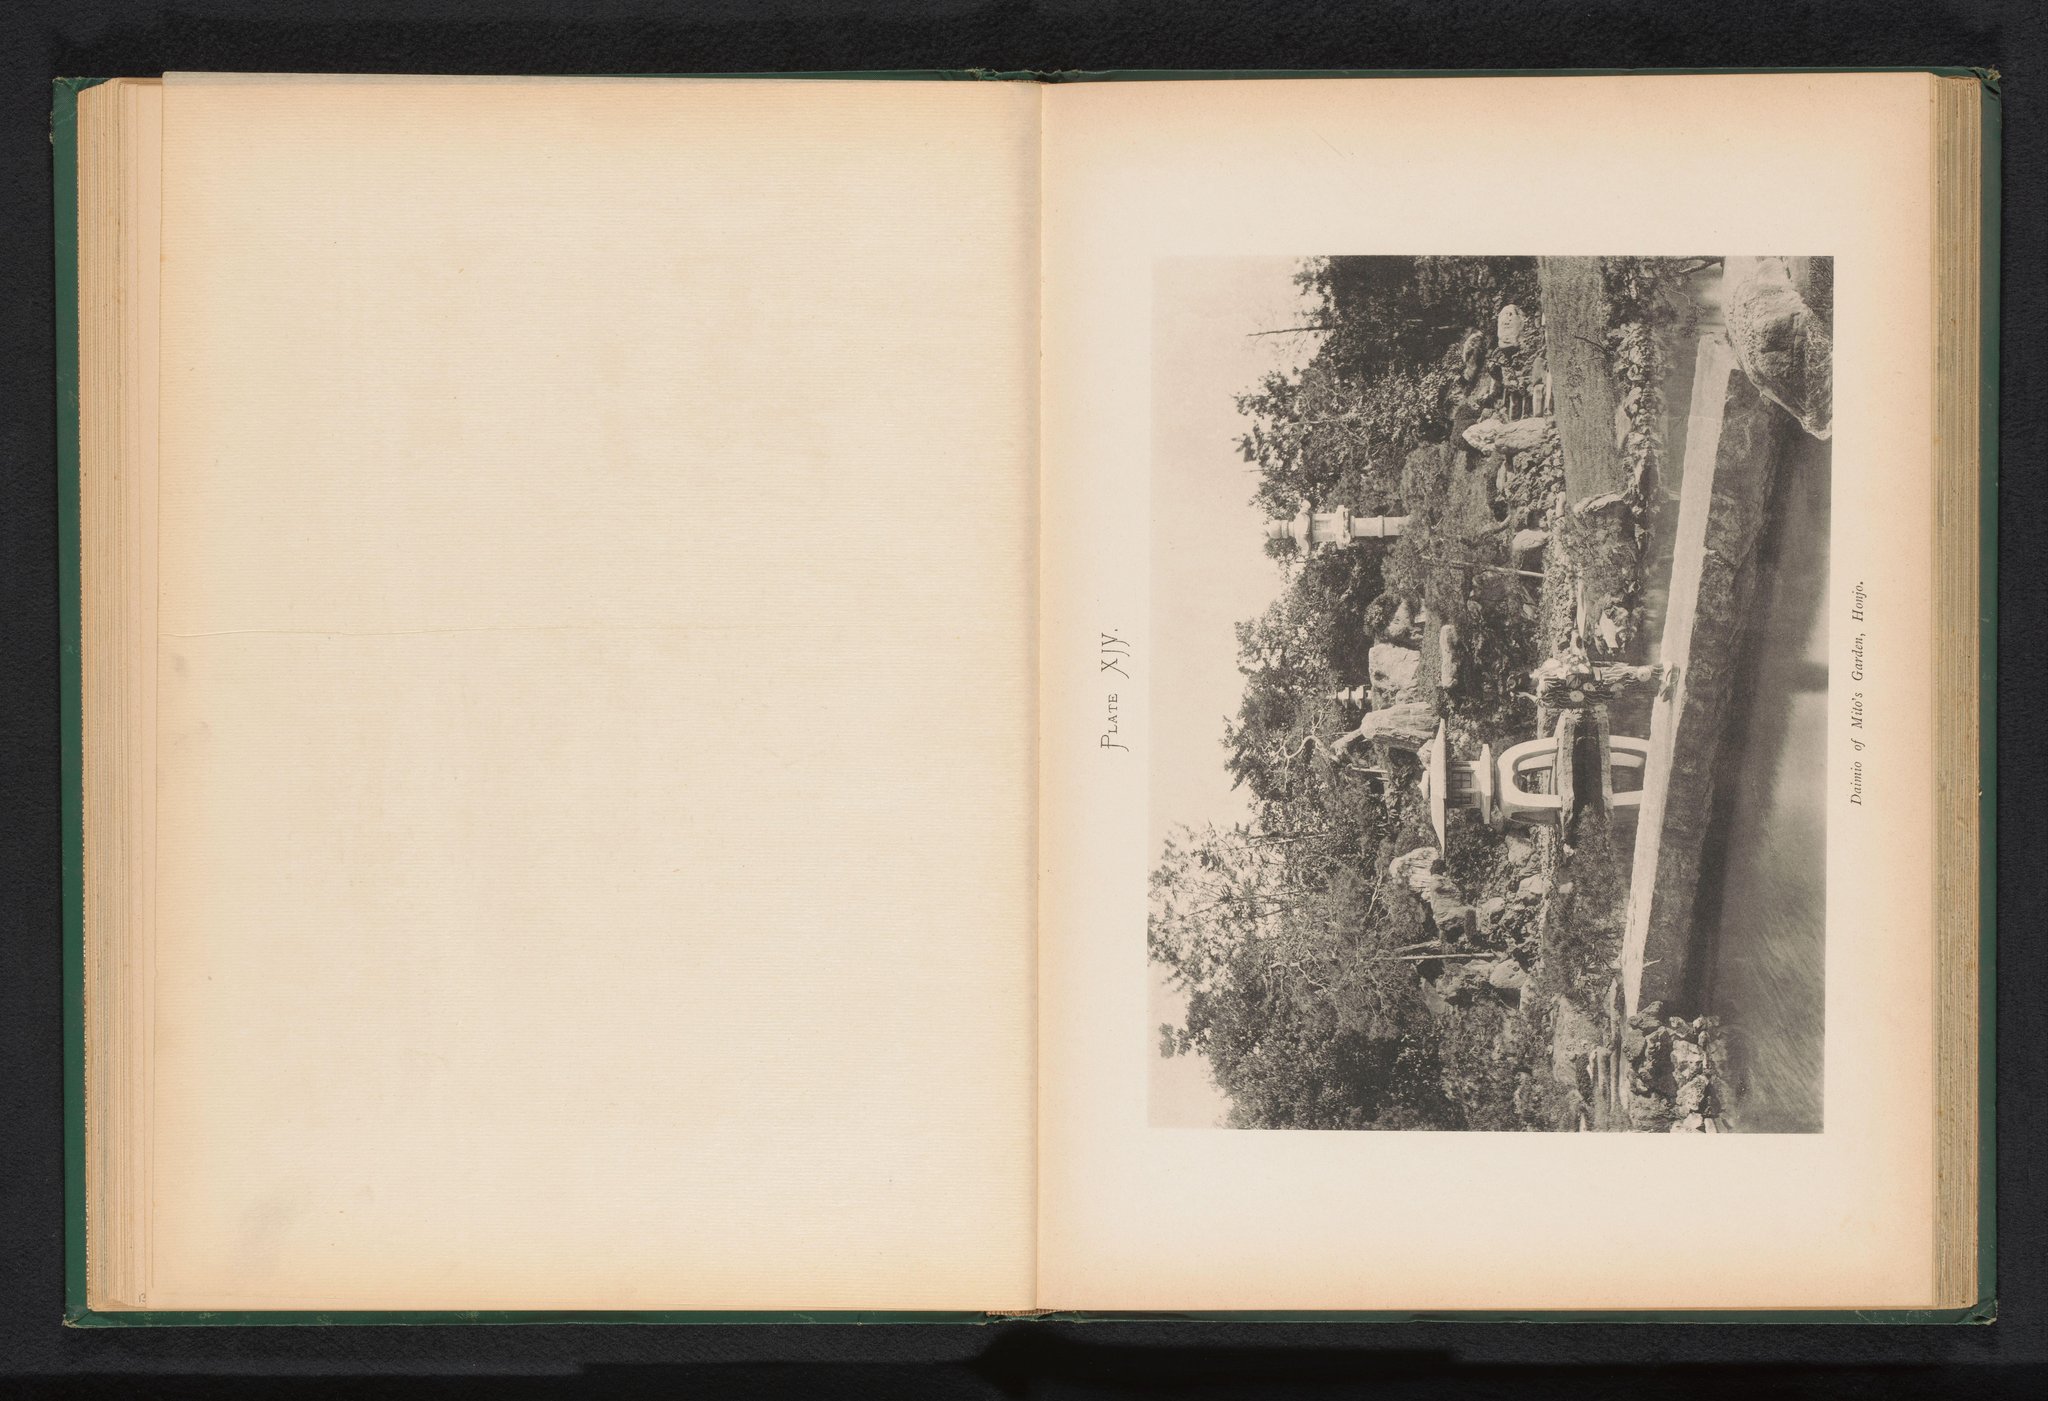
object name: page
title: Gezicht op de tuinen van de Daimio van Mito in Tokyo, Japan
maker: kazumasa ogawa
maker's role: auteur, fotograaf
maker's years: 1860-1929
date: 1888-1893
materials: paper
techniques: photograph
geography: tokyo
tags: garden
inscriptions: inscription: ‘Plate XIV.’